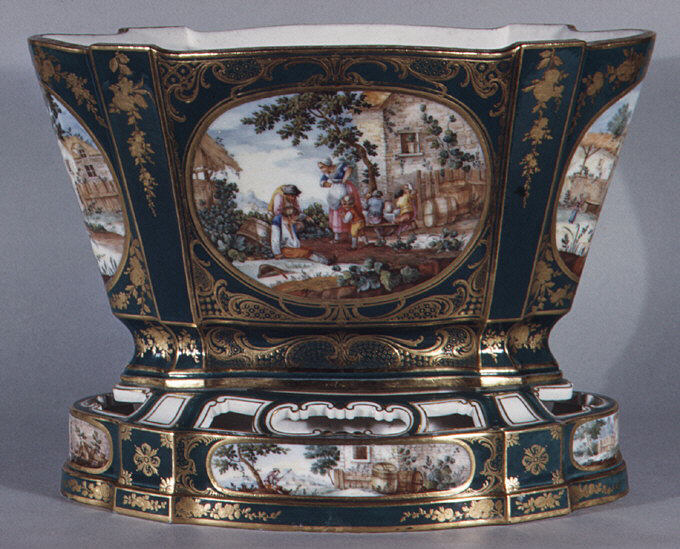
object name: vase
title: Vase (vase hollandais)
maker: sèvres manufactory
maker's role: manufactory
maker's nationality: french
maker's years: 1740-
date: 1761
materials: soft paste porcelain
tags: houses,women,trees